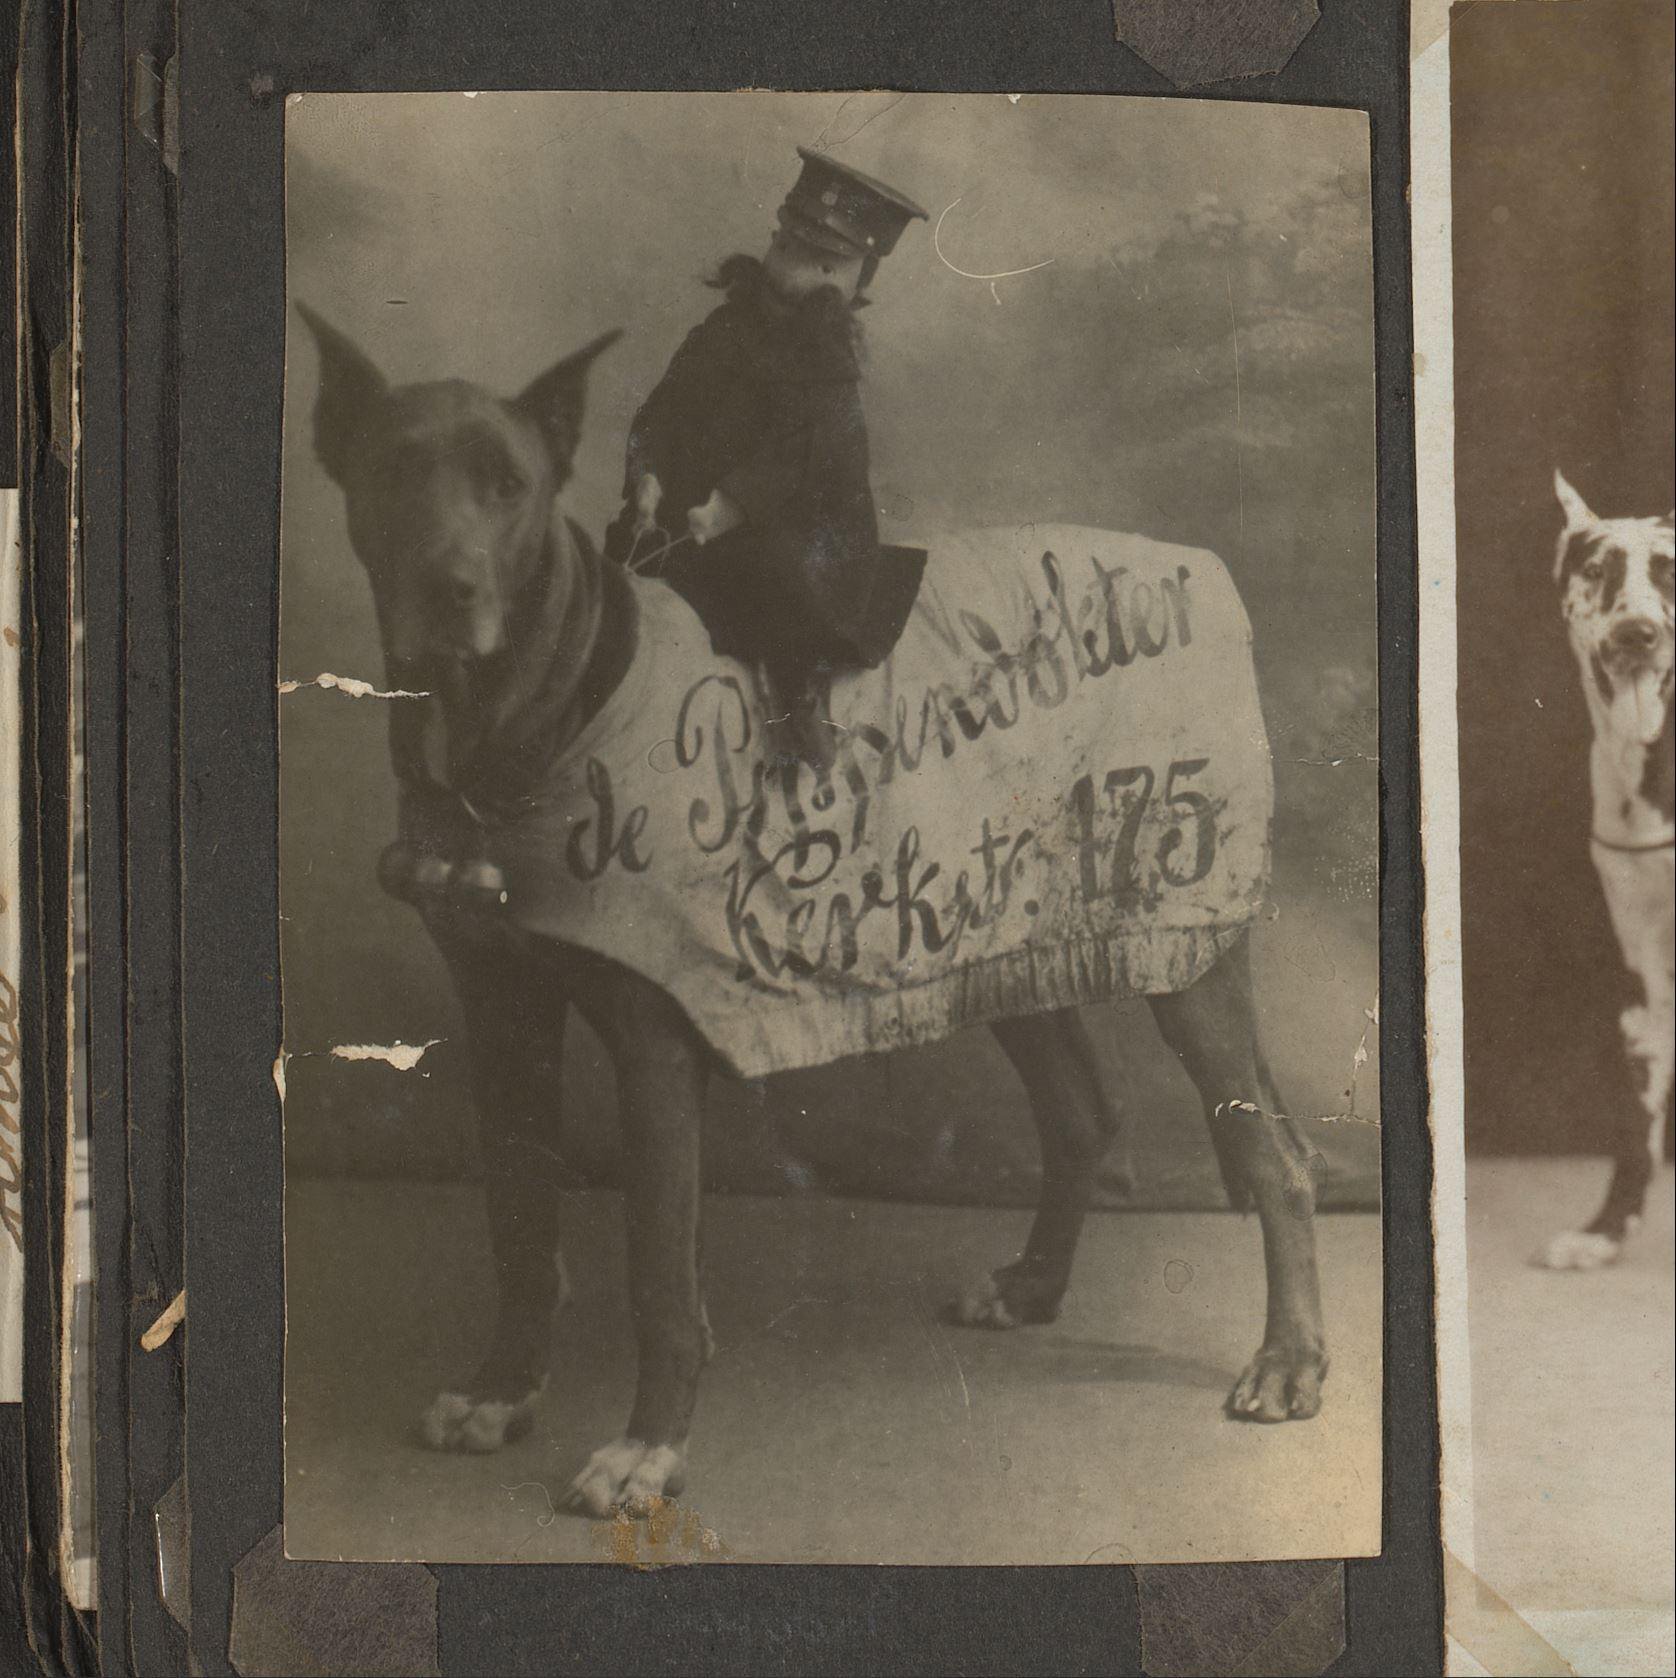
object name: photograph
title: Hond met reclametekst voor de poppendokter met agentenpop op de rug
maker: Anonymous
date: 1930-1940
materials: photographic support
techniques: gelatin silver print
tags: advertising, dolls for adults, dog, amsterdam